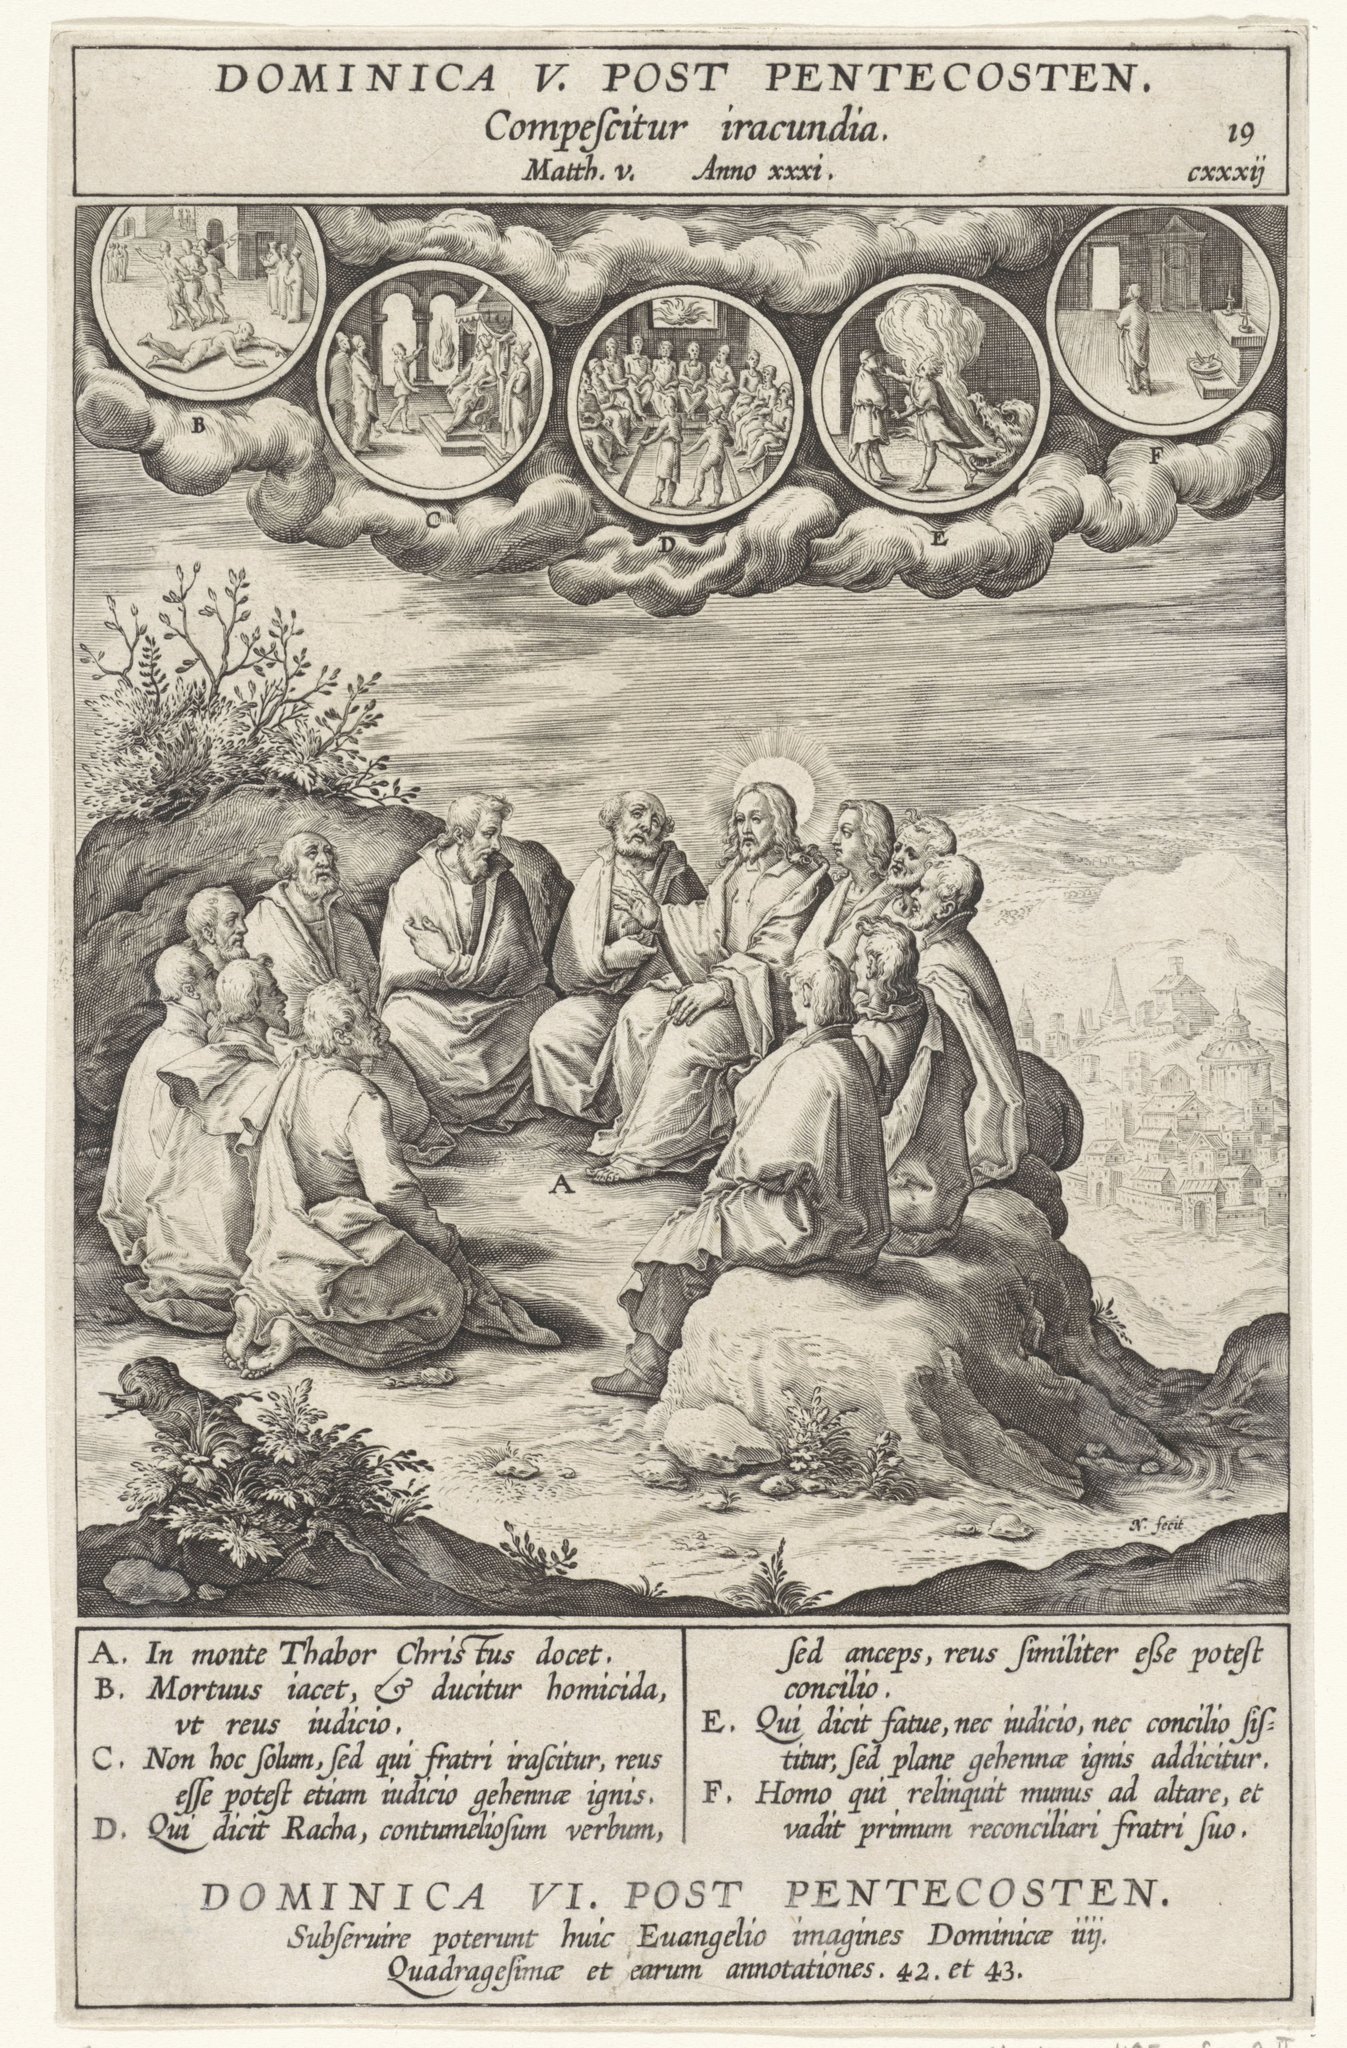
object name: print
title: Bergrede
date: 1593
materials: paper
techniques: engraving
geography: antwerp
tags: christ's sermon on the mount (matthew 5-7)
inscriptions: collector's mark: Lugt 2165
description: Christus zit op de top van een berg en zet zijn leer uiteen. Hij is omringd door mannen die naar hem luisteren. Bovenaan in medaillons diverse scènes. Bij verschillende elementen uit de voorstelling staan letters die corresponderen met de legenda in de marge.